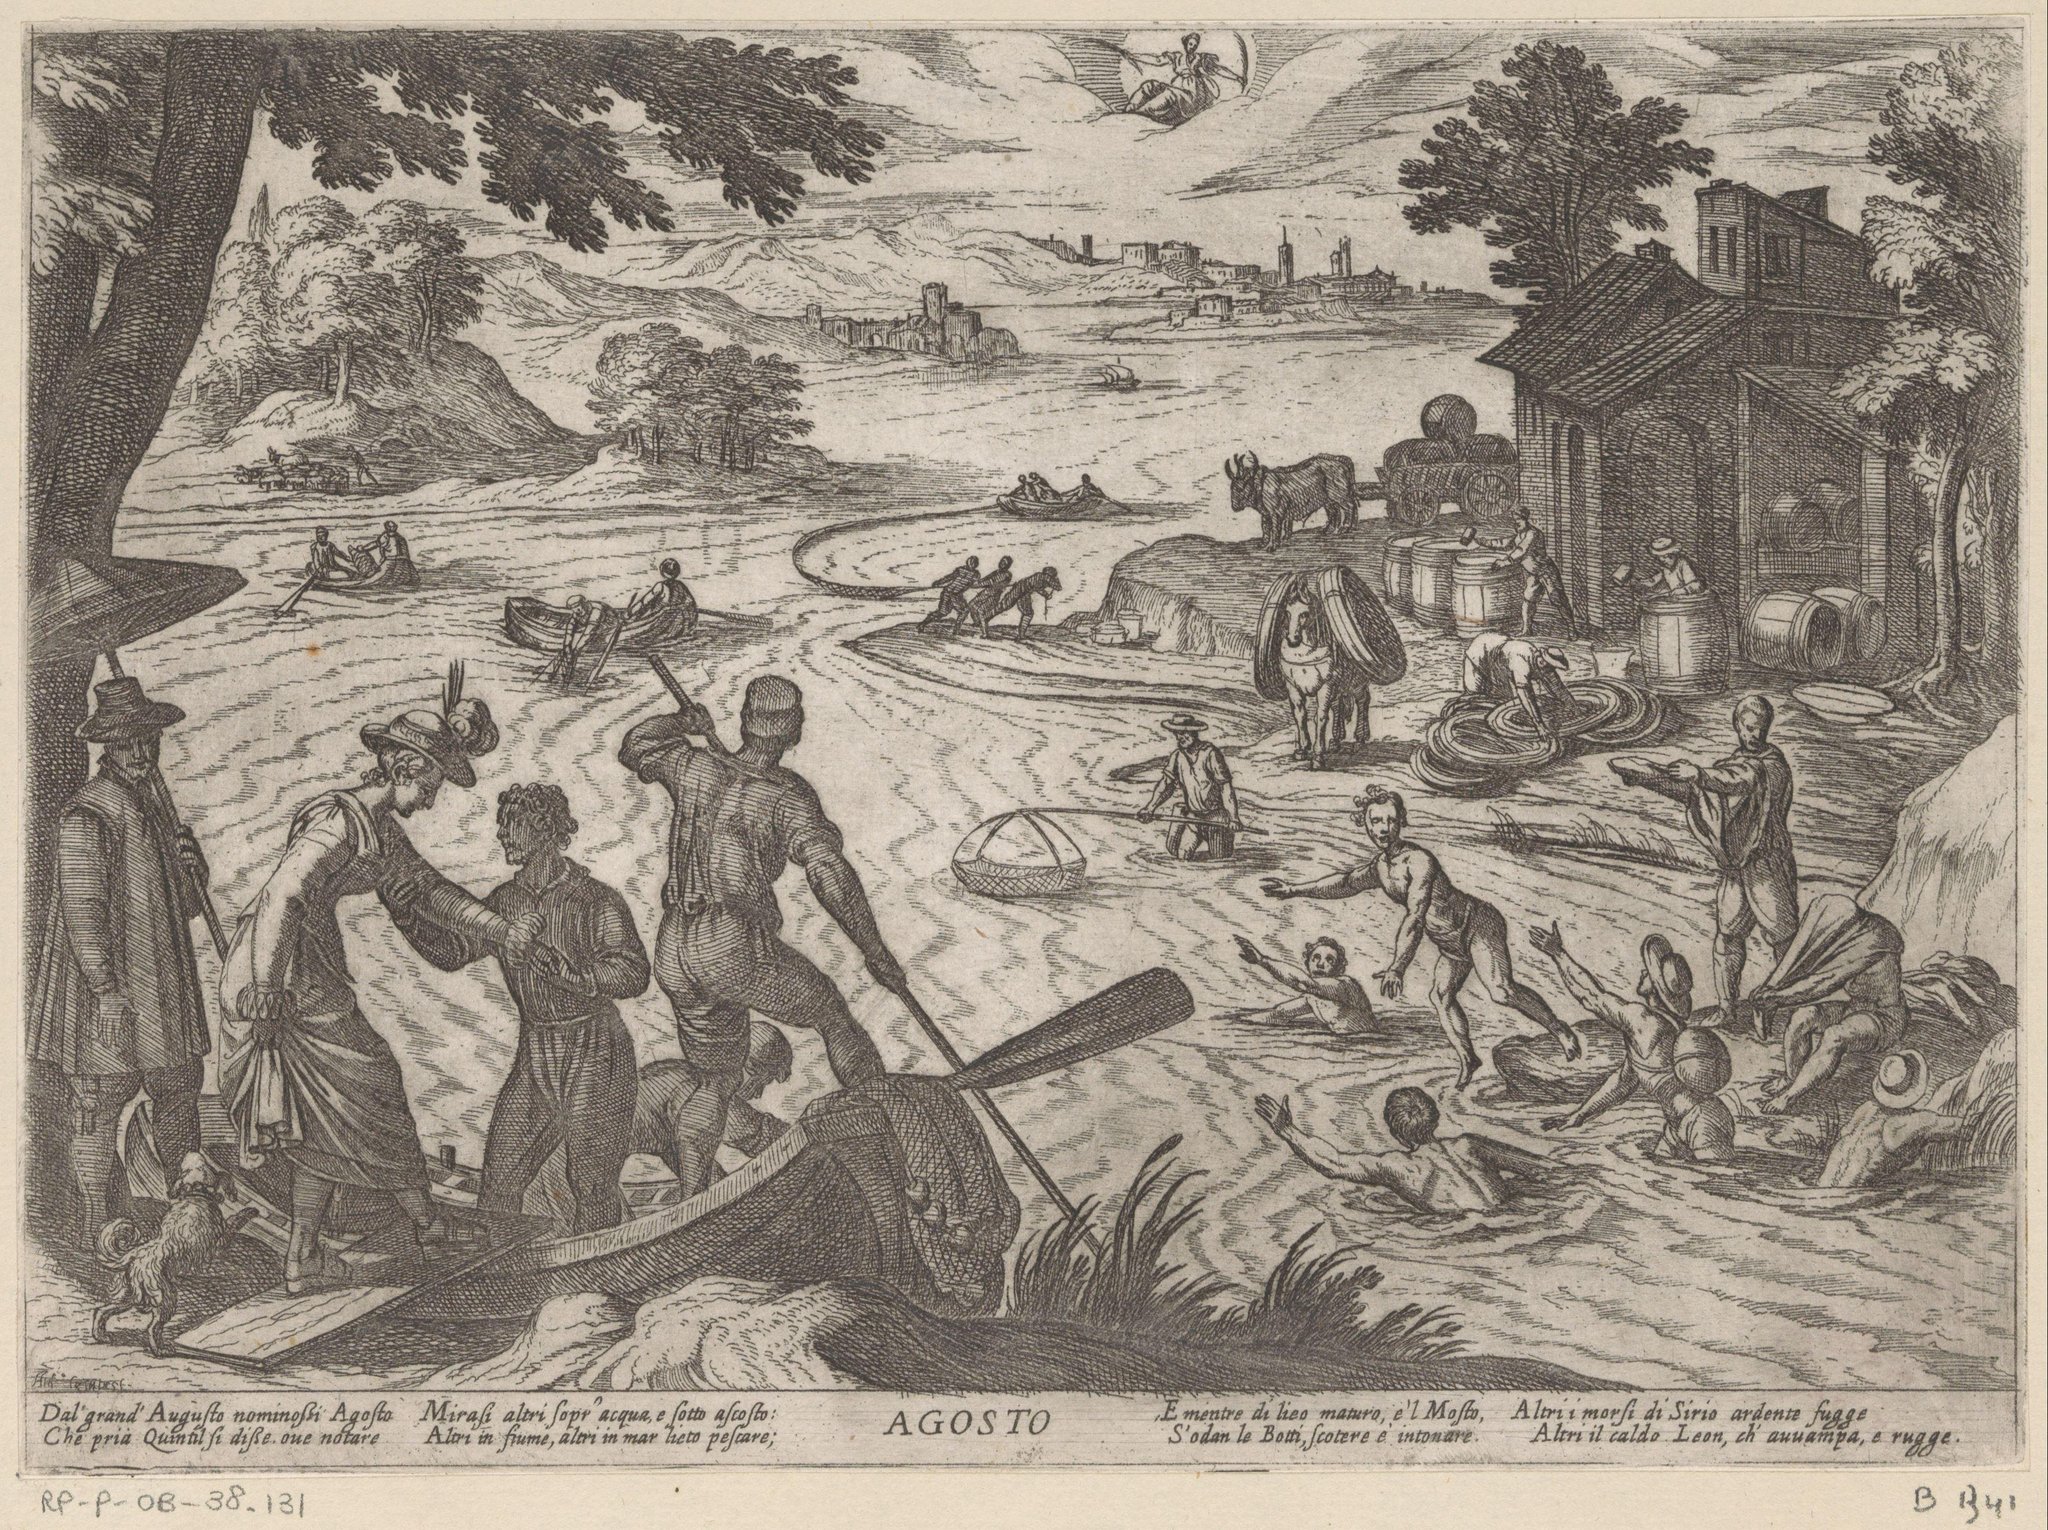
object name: print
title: Augustus: vissen (maagd)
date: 1599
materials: paper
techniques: etching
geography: italy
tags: virgo (zodiacal sign of august), fishing net, the twelve months represented by scenes showing human activities, usually in a landscape; so-called 'labours of the months', rowing facing backward, pulling, swimming (movement in water), fisherman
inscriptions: collector's mark: Lugt 240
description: Verbeelding van menselijke activiteit in de maand augustus. Rivierlandschap met vissers en mensen die in het water zwemmen of op het water roeien. Midden boven het symbool voor het sterrenbeeld maagd. Italiaans vers en titel in ondermarge.